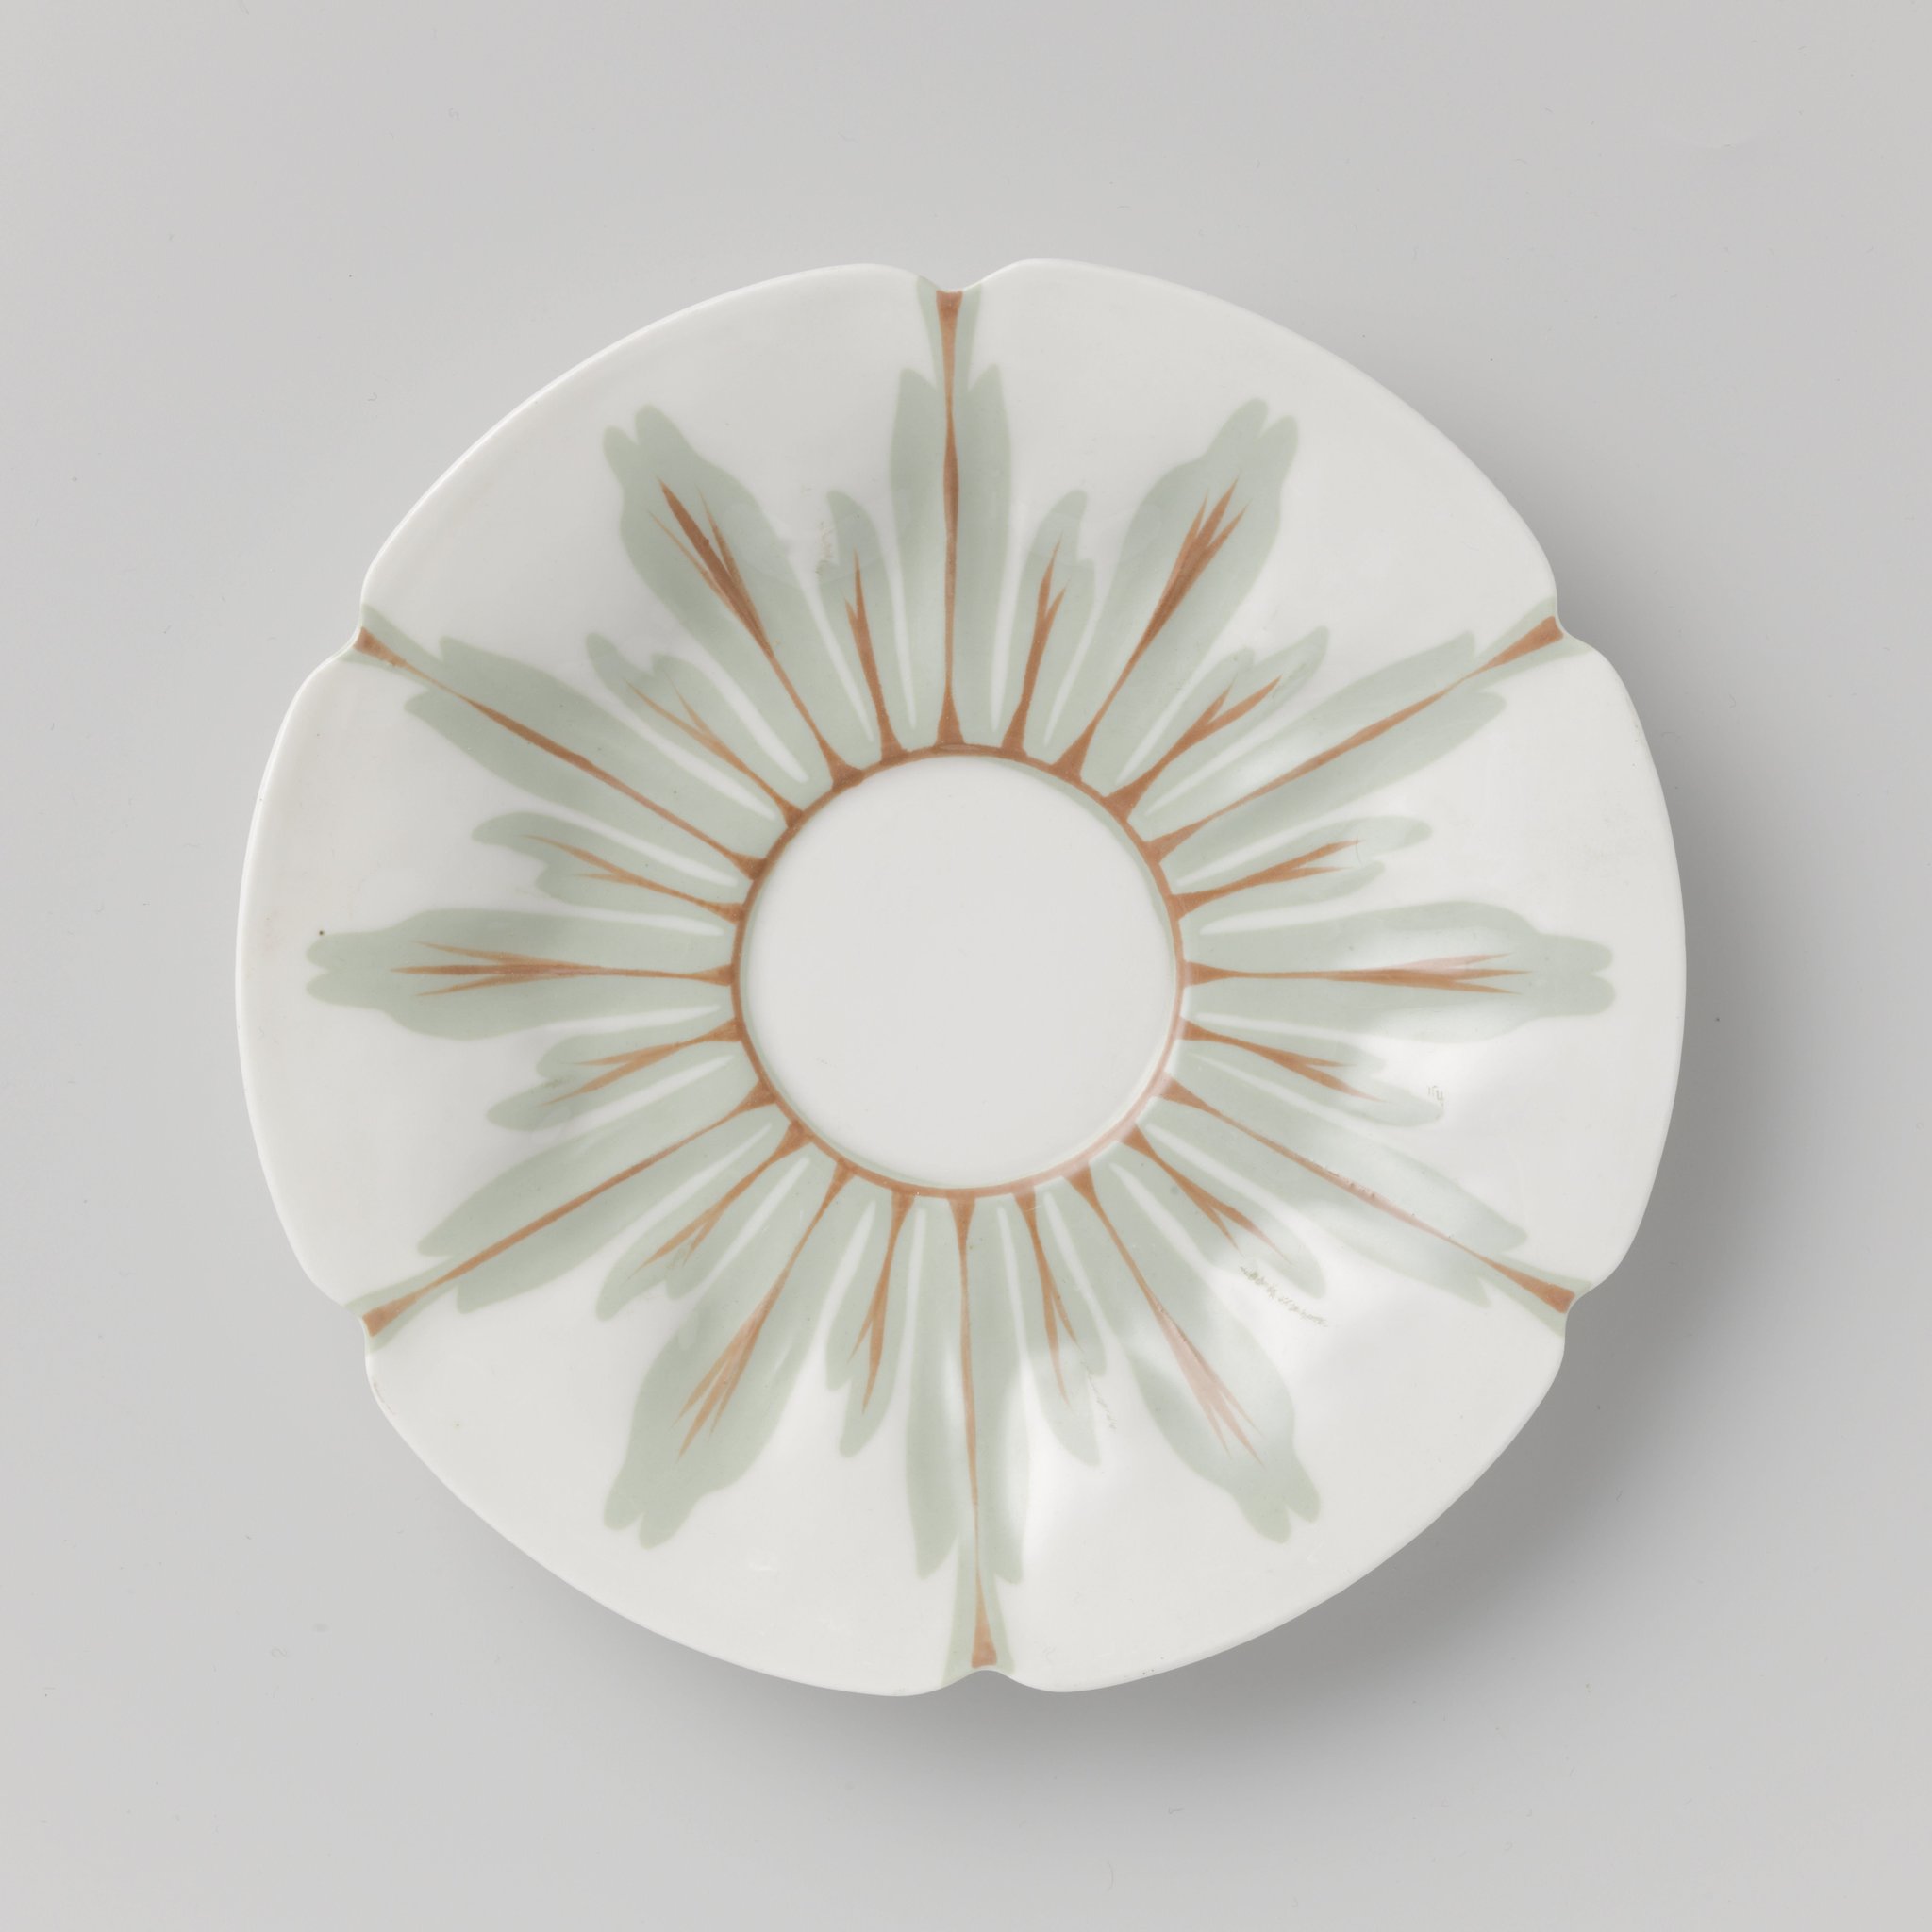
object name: platter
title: Schotel, beschilderd met het Krokus-decor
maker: konrad hentschel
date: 1896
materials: porcelain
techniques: painted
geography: meissen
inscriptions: mark: ‘69’, mold mark: ‘Q111’, factory mark, mark: ‘71’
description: Schotel van beschilderd porselein. De schotel is beschilderd in groen en bruin. De schotel is gemerkt.